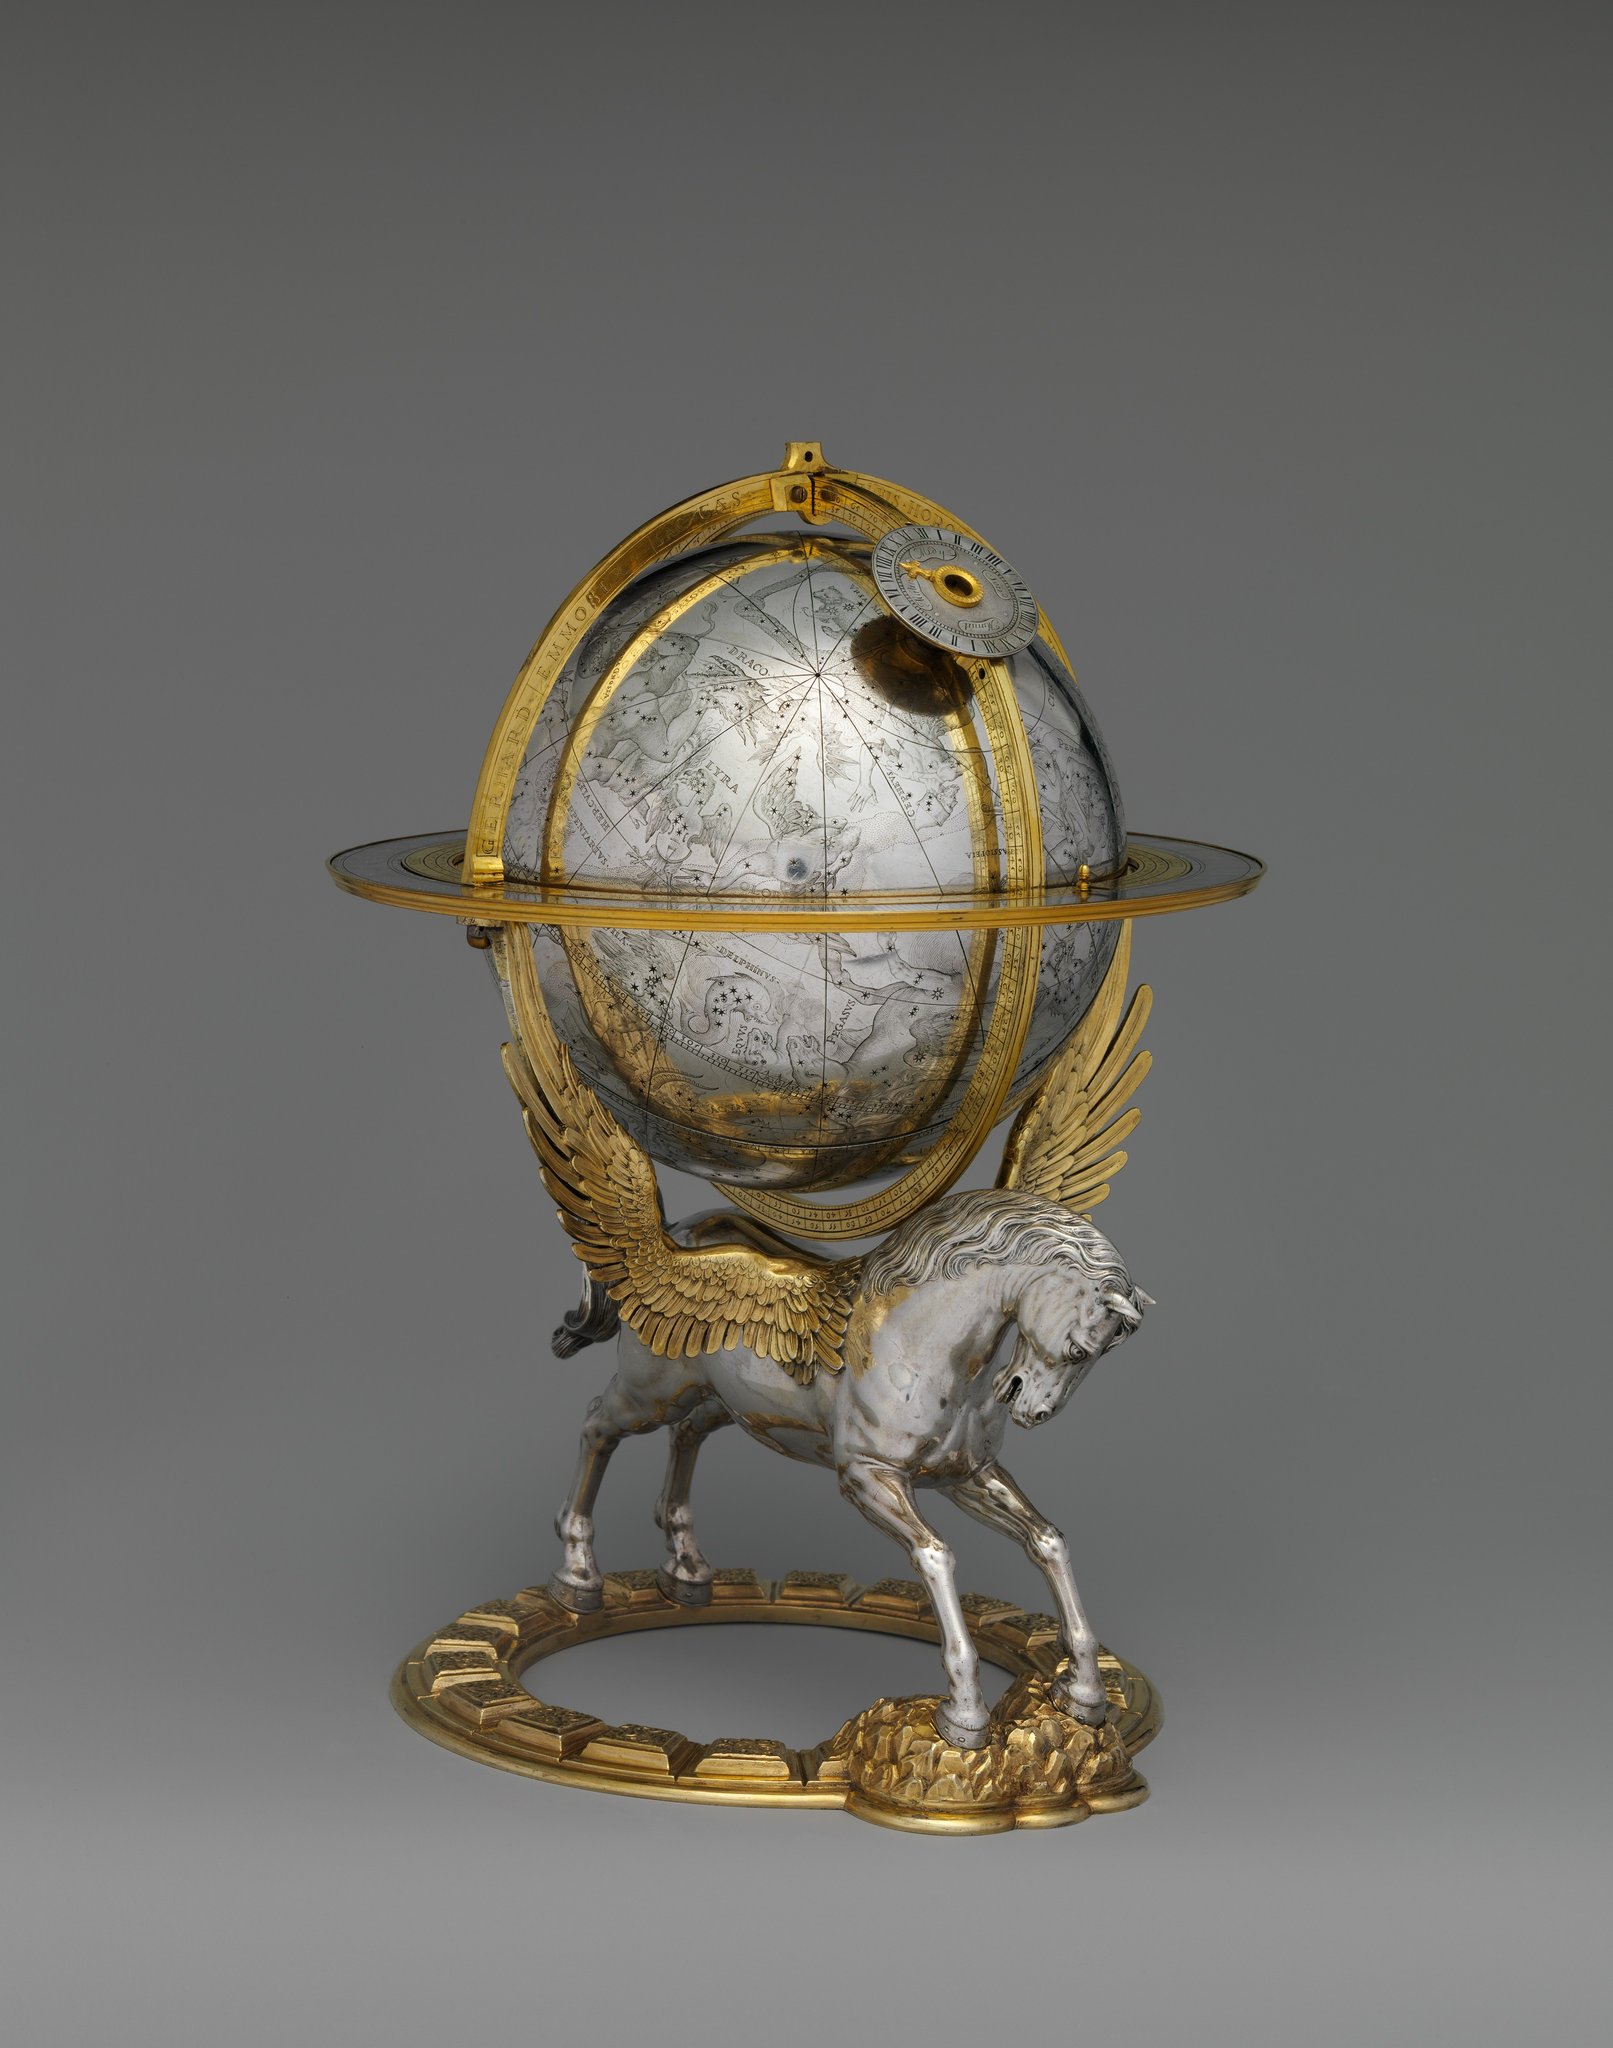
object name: celestial globe with clockwork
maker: gerhard emmoser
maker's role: maker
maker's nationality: german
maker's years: 1484-1584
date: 1579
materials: brass, gilt brass, gilt silver, steel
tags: pegasus,astronomy,globes